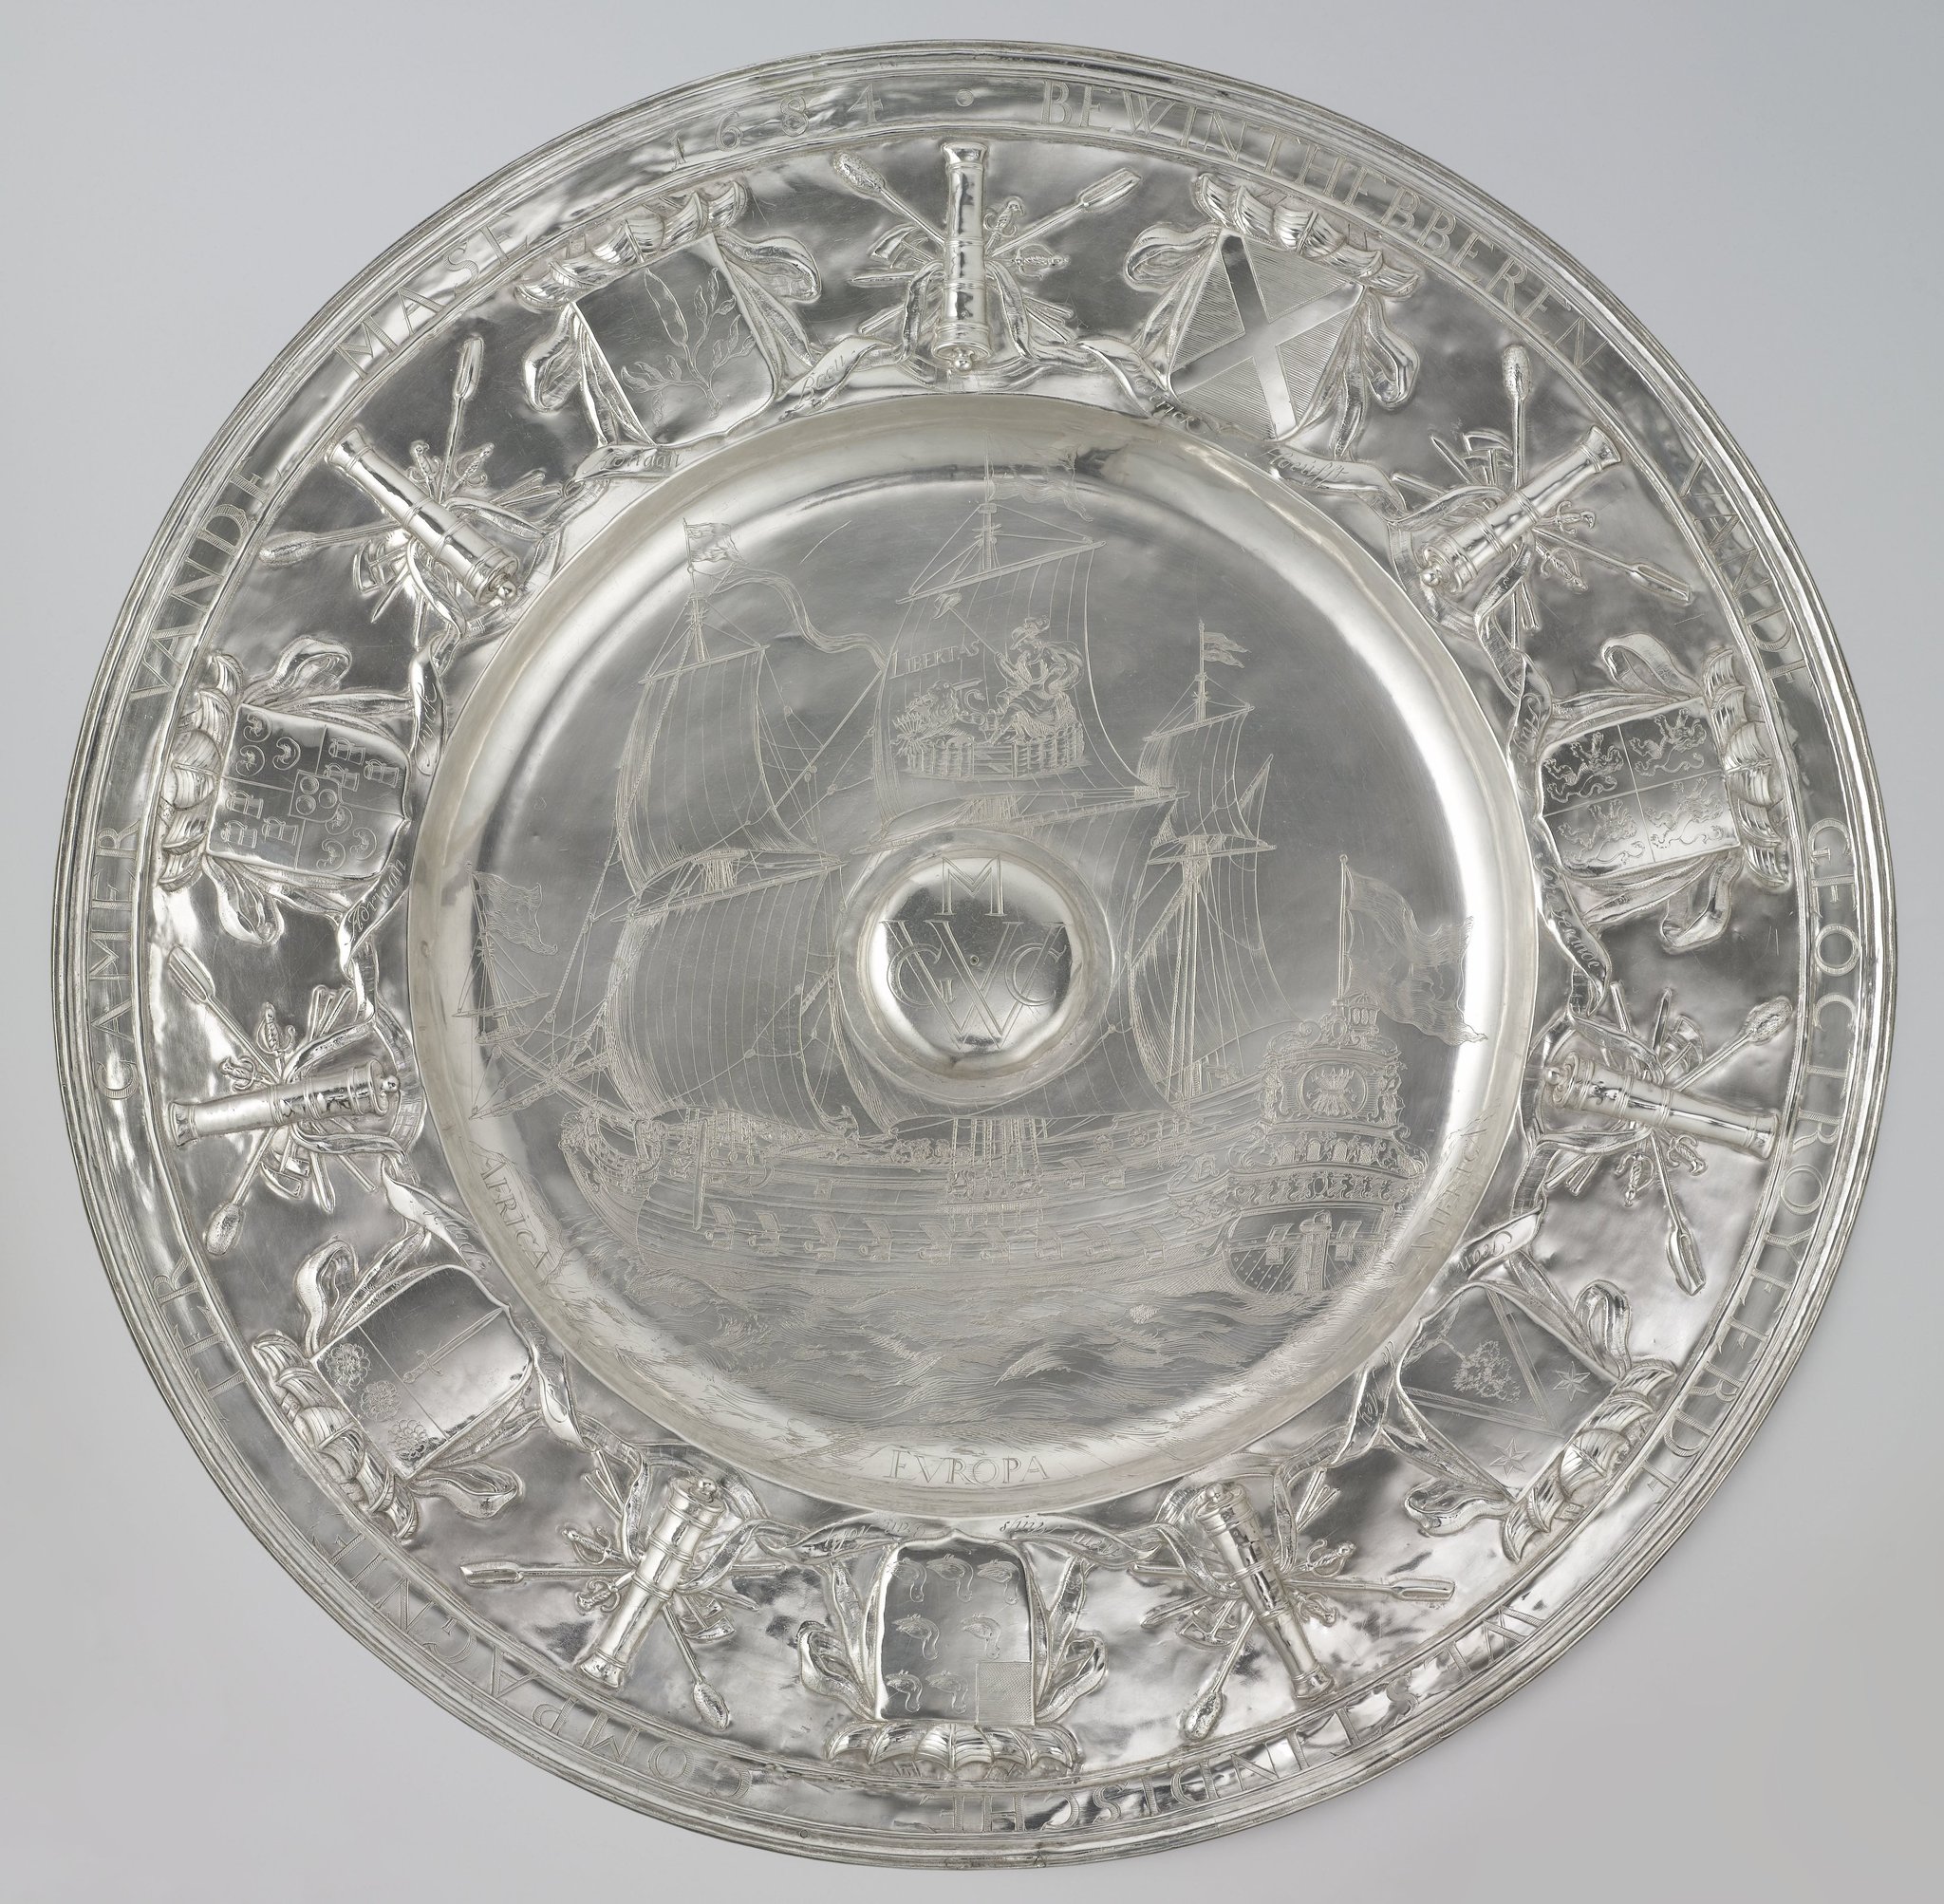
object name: dish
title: Piet Heyn dish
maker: Anonymous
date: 1684-1687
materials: silver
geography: the hague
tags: delfshaven, sailing-ship, sailing-boat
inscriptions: mark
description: Piet Heyn became famous for his conquest of the Spanish ‘Silver Fleet’ in 1628. The Spanish ships were laden with Mexican silver. The sale of the spoils yielded an astronomical fifteen million guilders. It was a painful blow for Spain, particularly because the Netherlands used the money to wage war against the Spanish. This dish was fashioned from the seized silver.